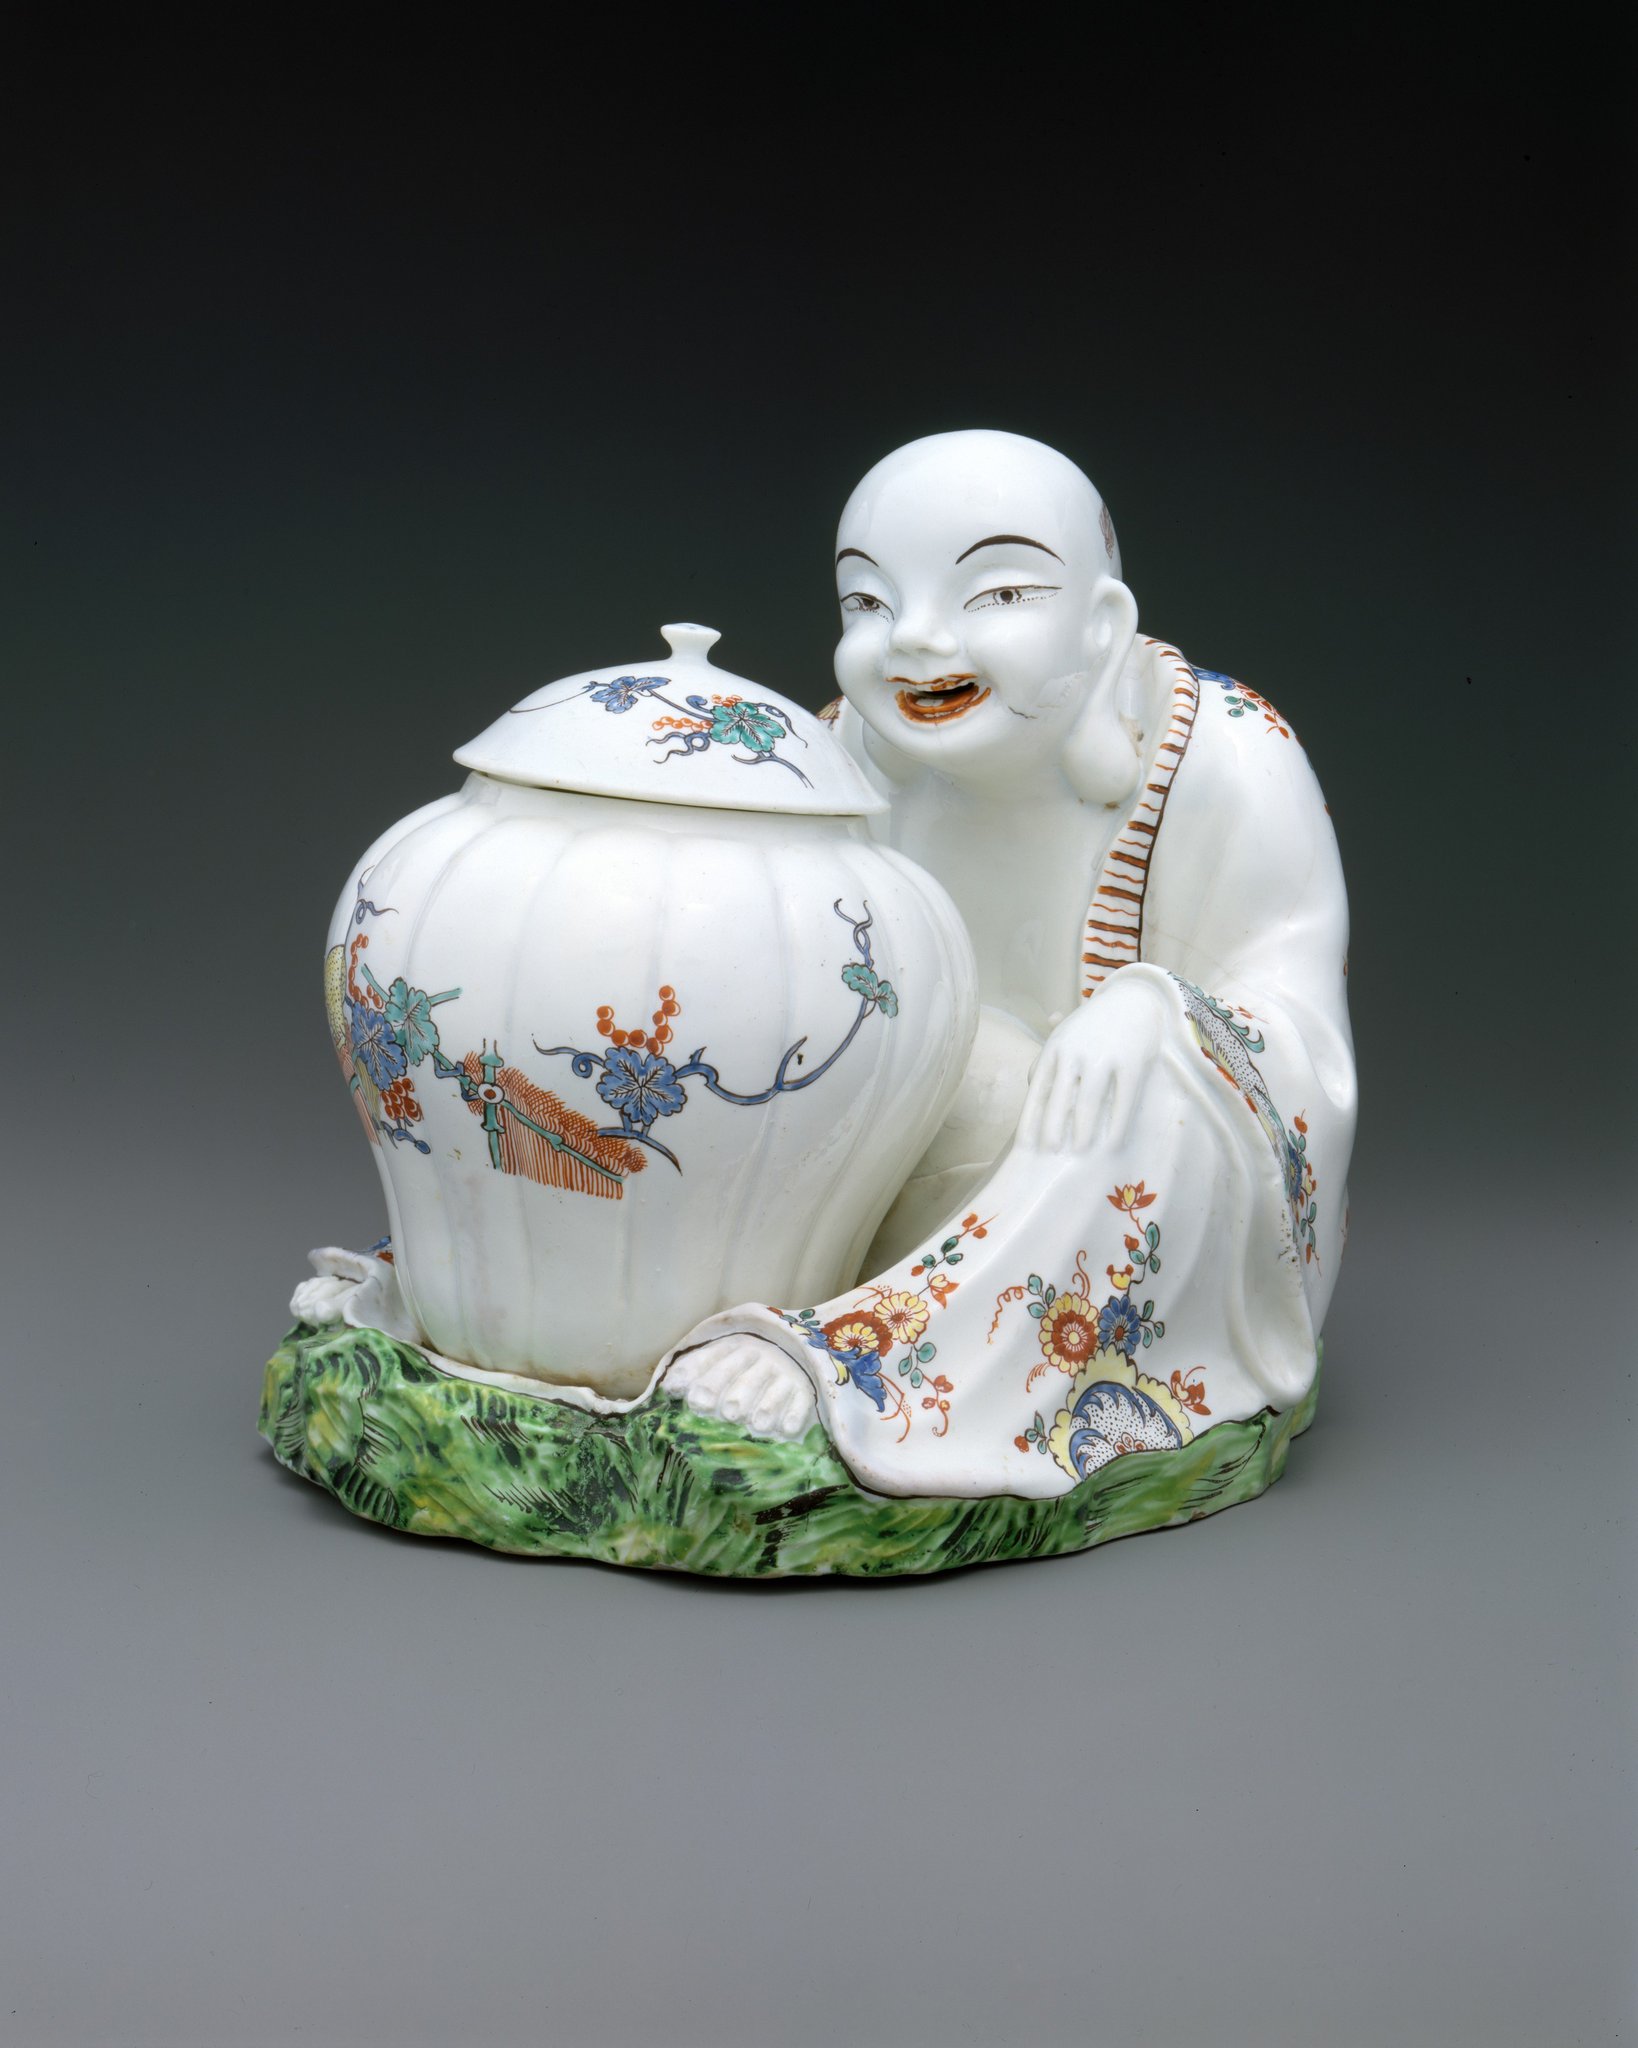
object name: jar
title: Oriental with Jar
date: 1735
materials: soft paste porcelain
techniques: glazing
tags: men,flowers